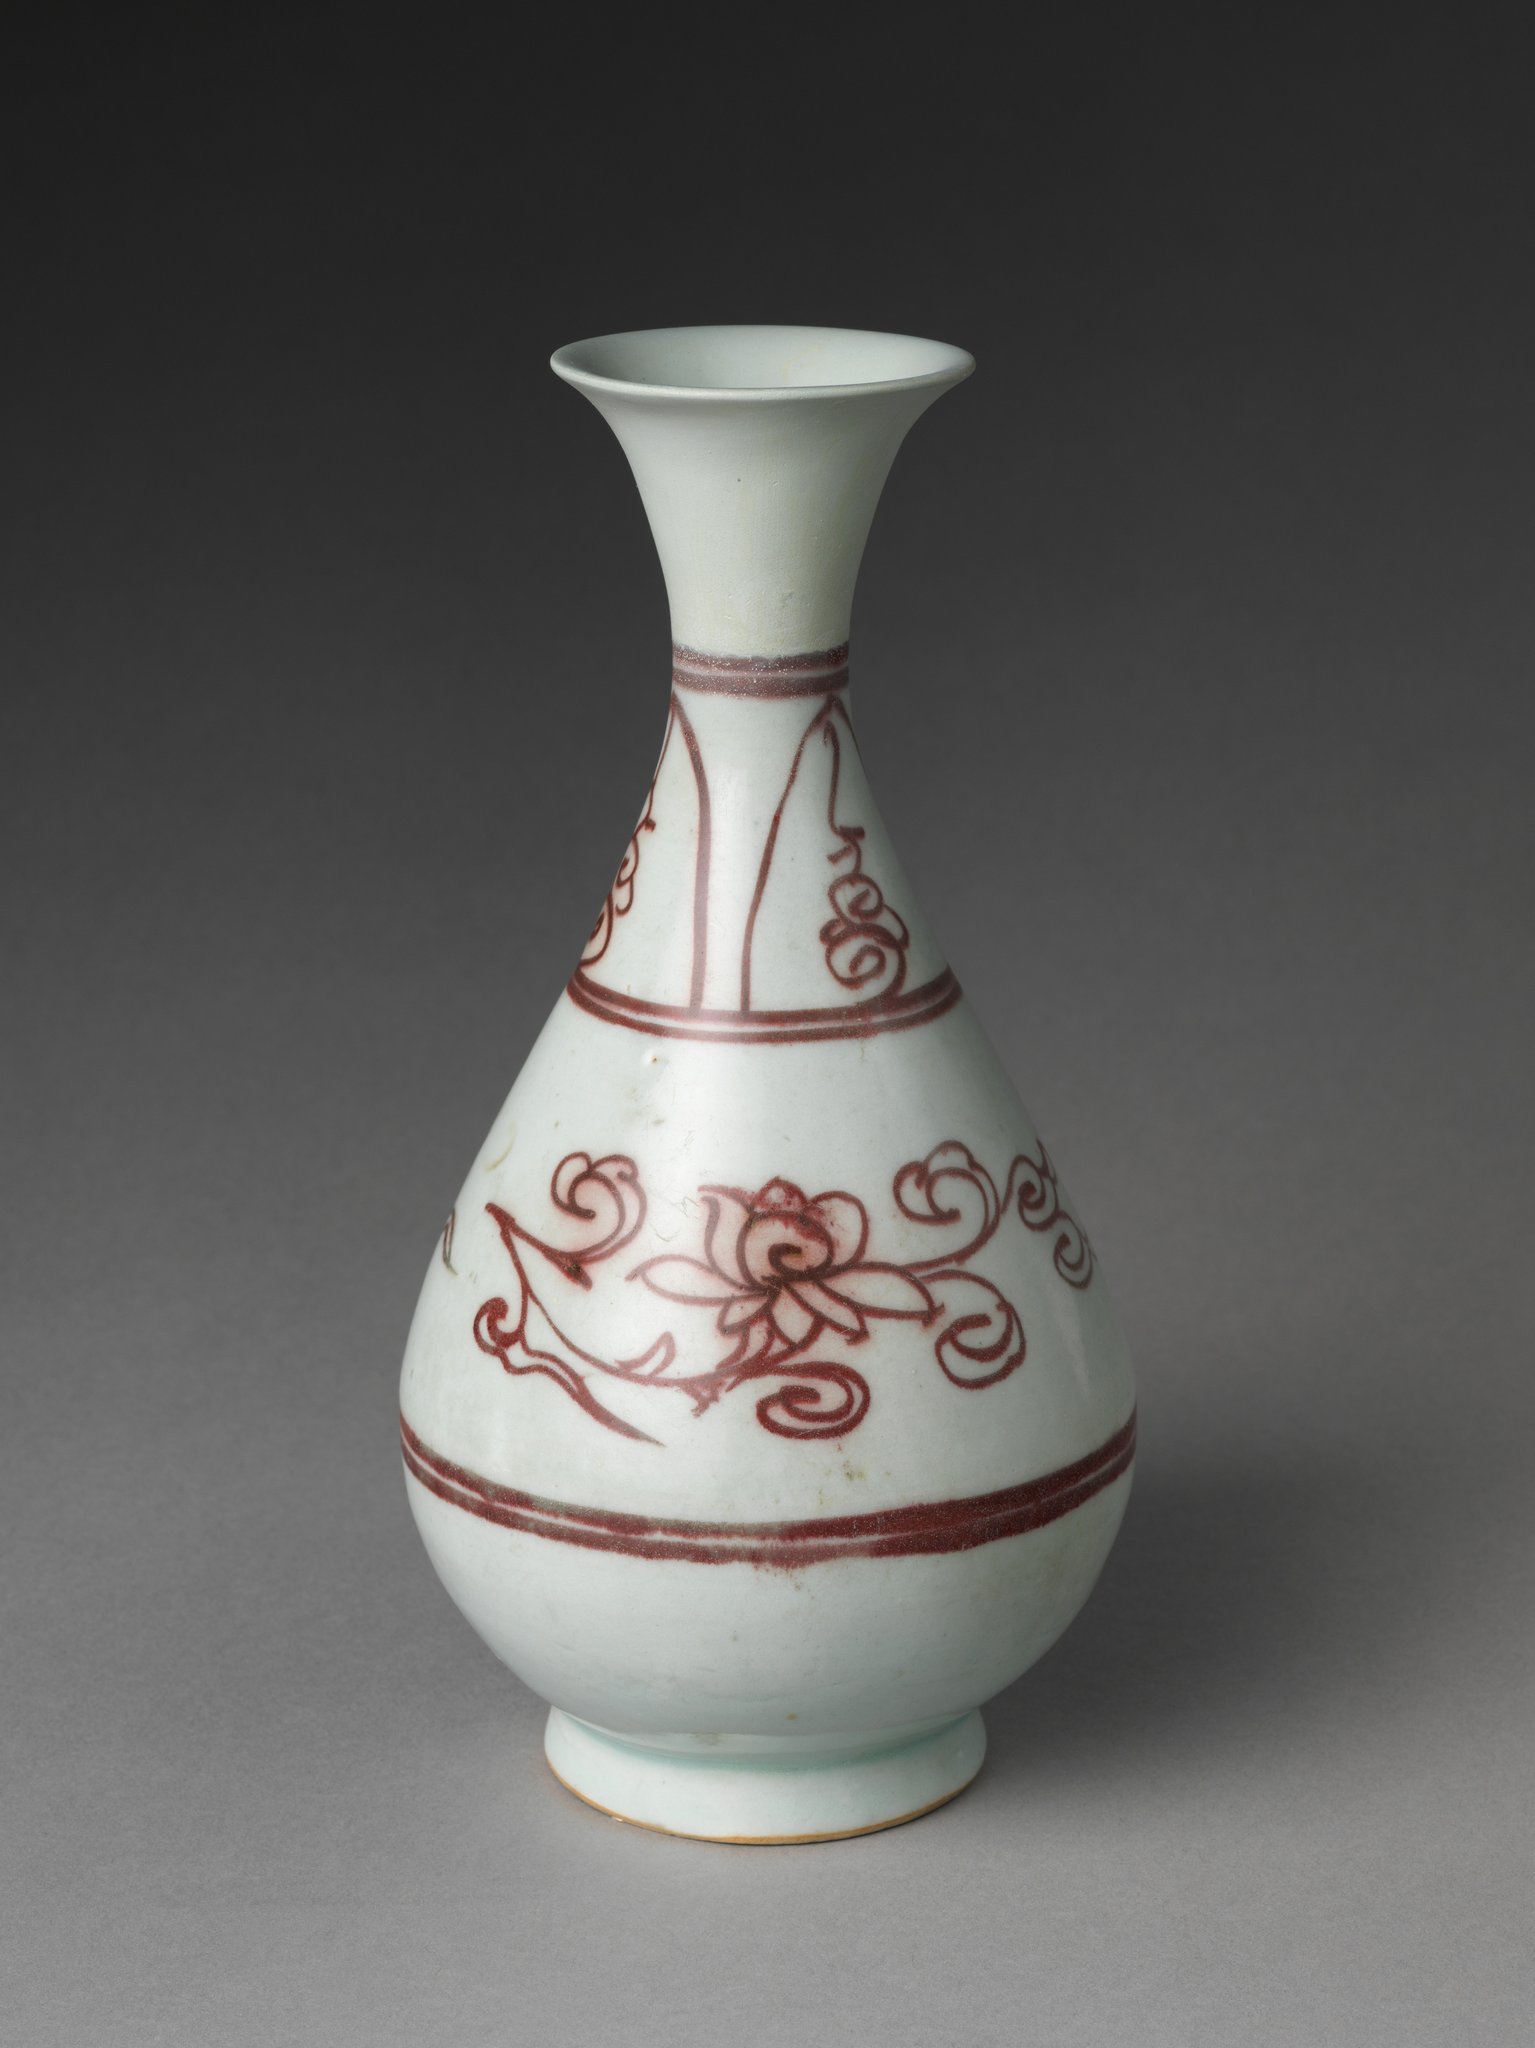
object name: bottle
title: Bottle with Peonies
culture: chinese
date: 1334-1366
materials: copper, glaze, porcelain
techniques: painting